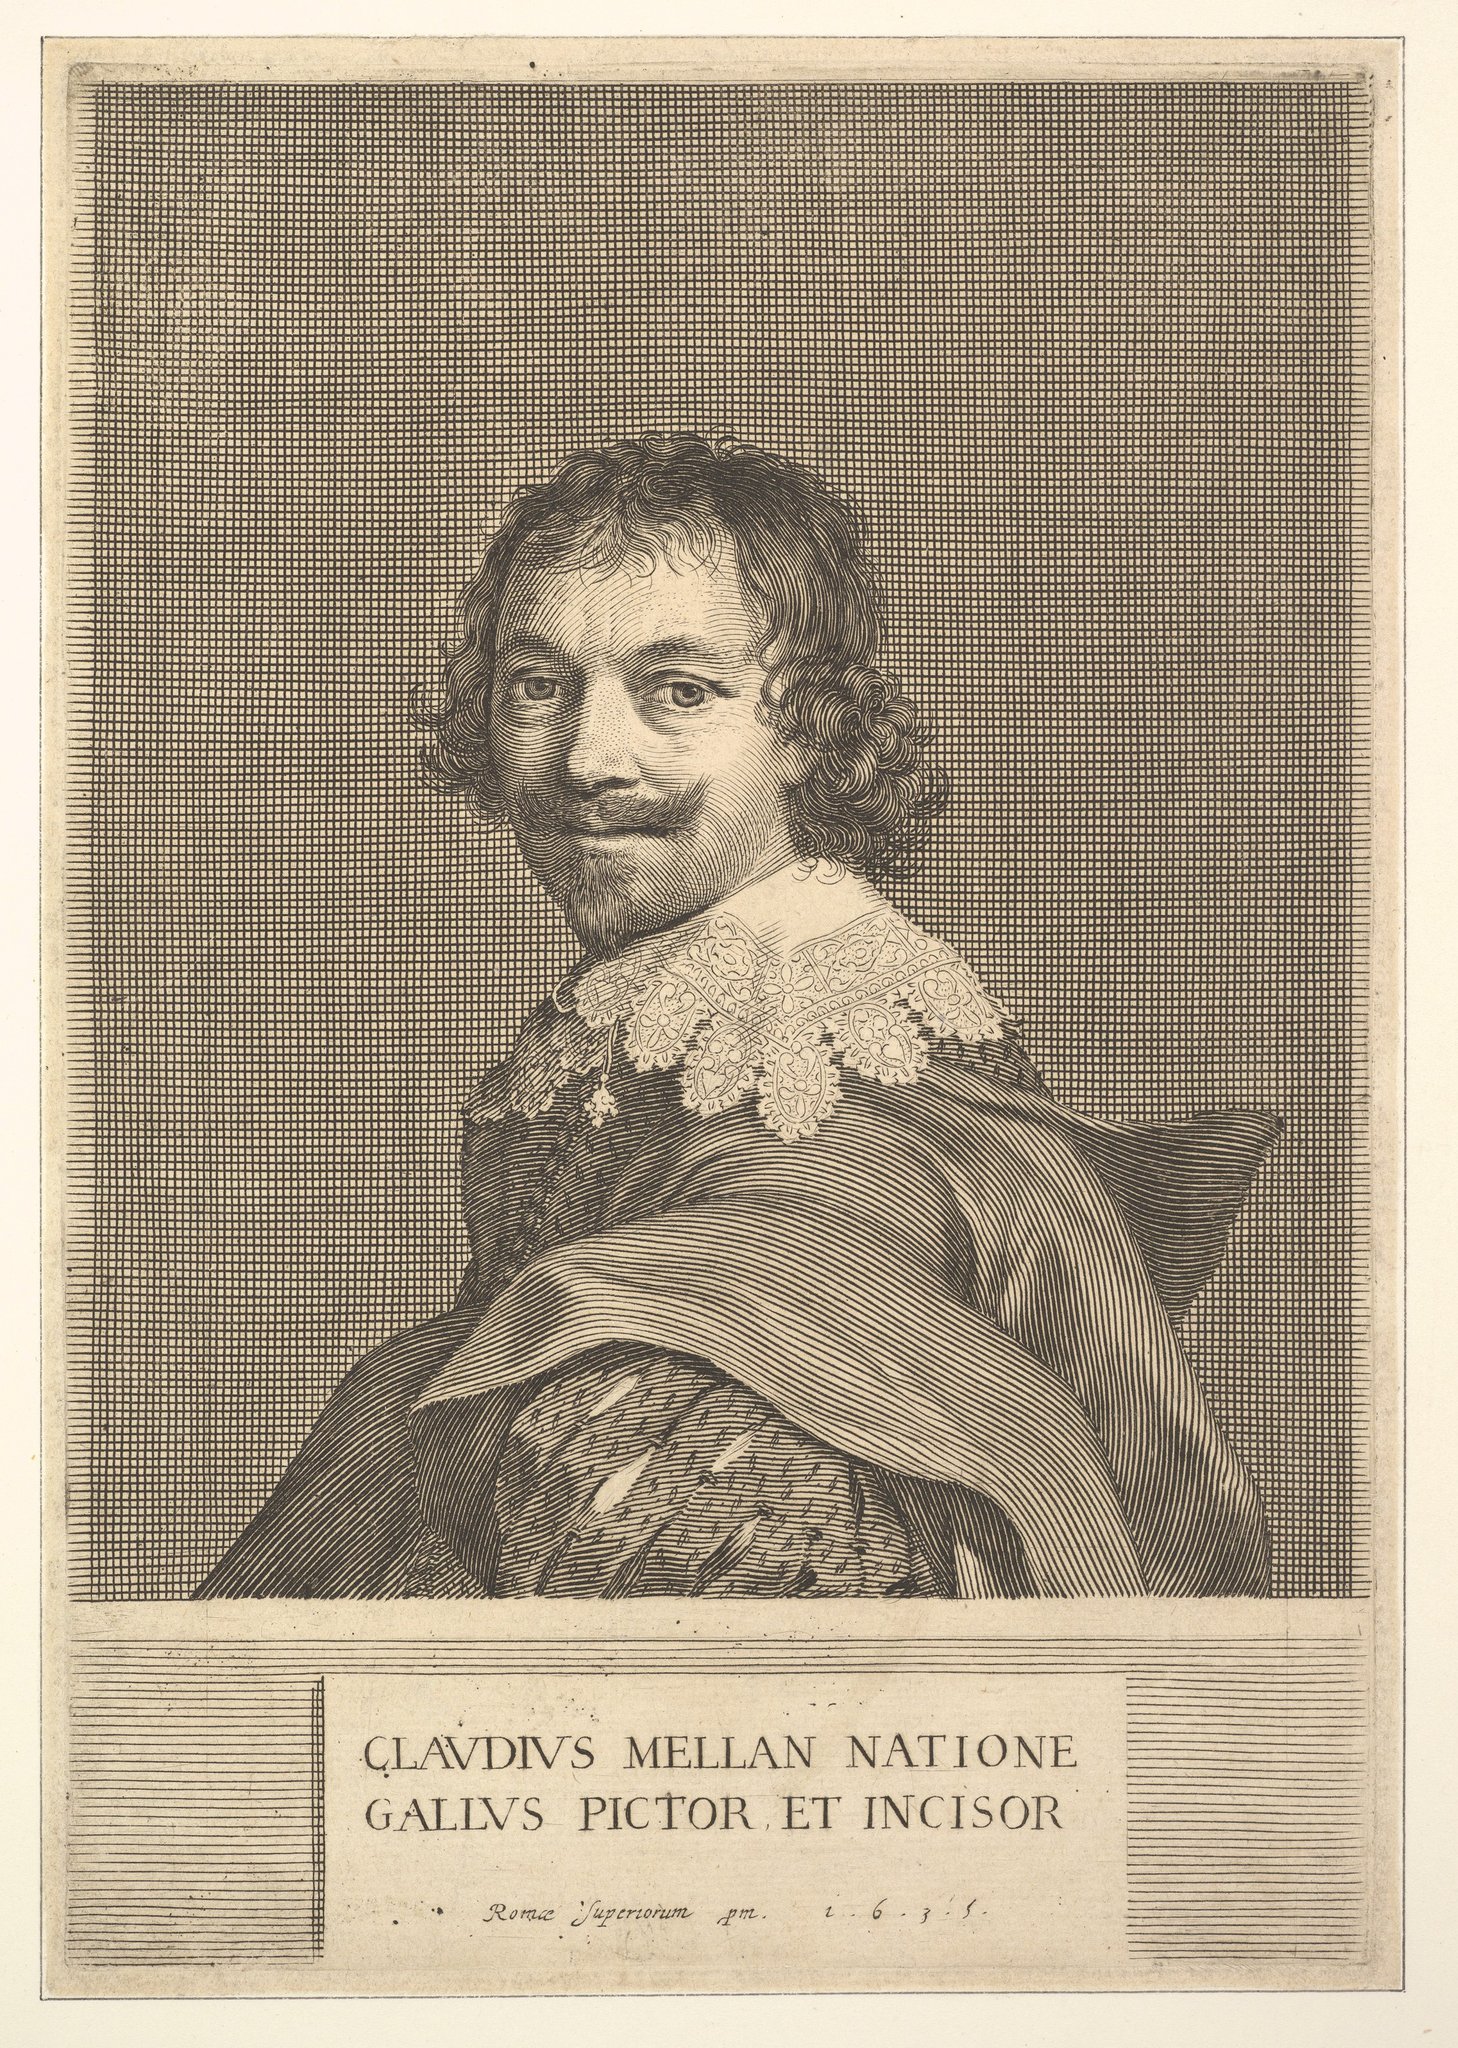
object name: print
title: Claude Mellan: Self Portrait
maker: claude mellan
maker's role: artist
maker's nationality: french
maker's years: 1598-1688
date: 1635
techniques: engraving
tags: men,self-portraits